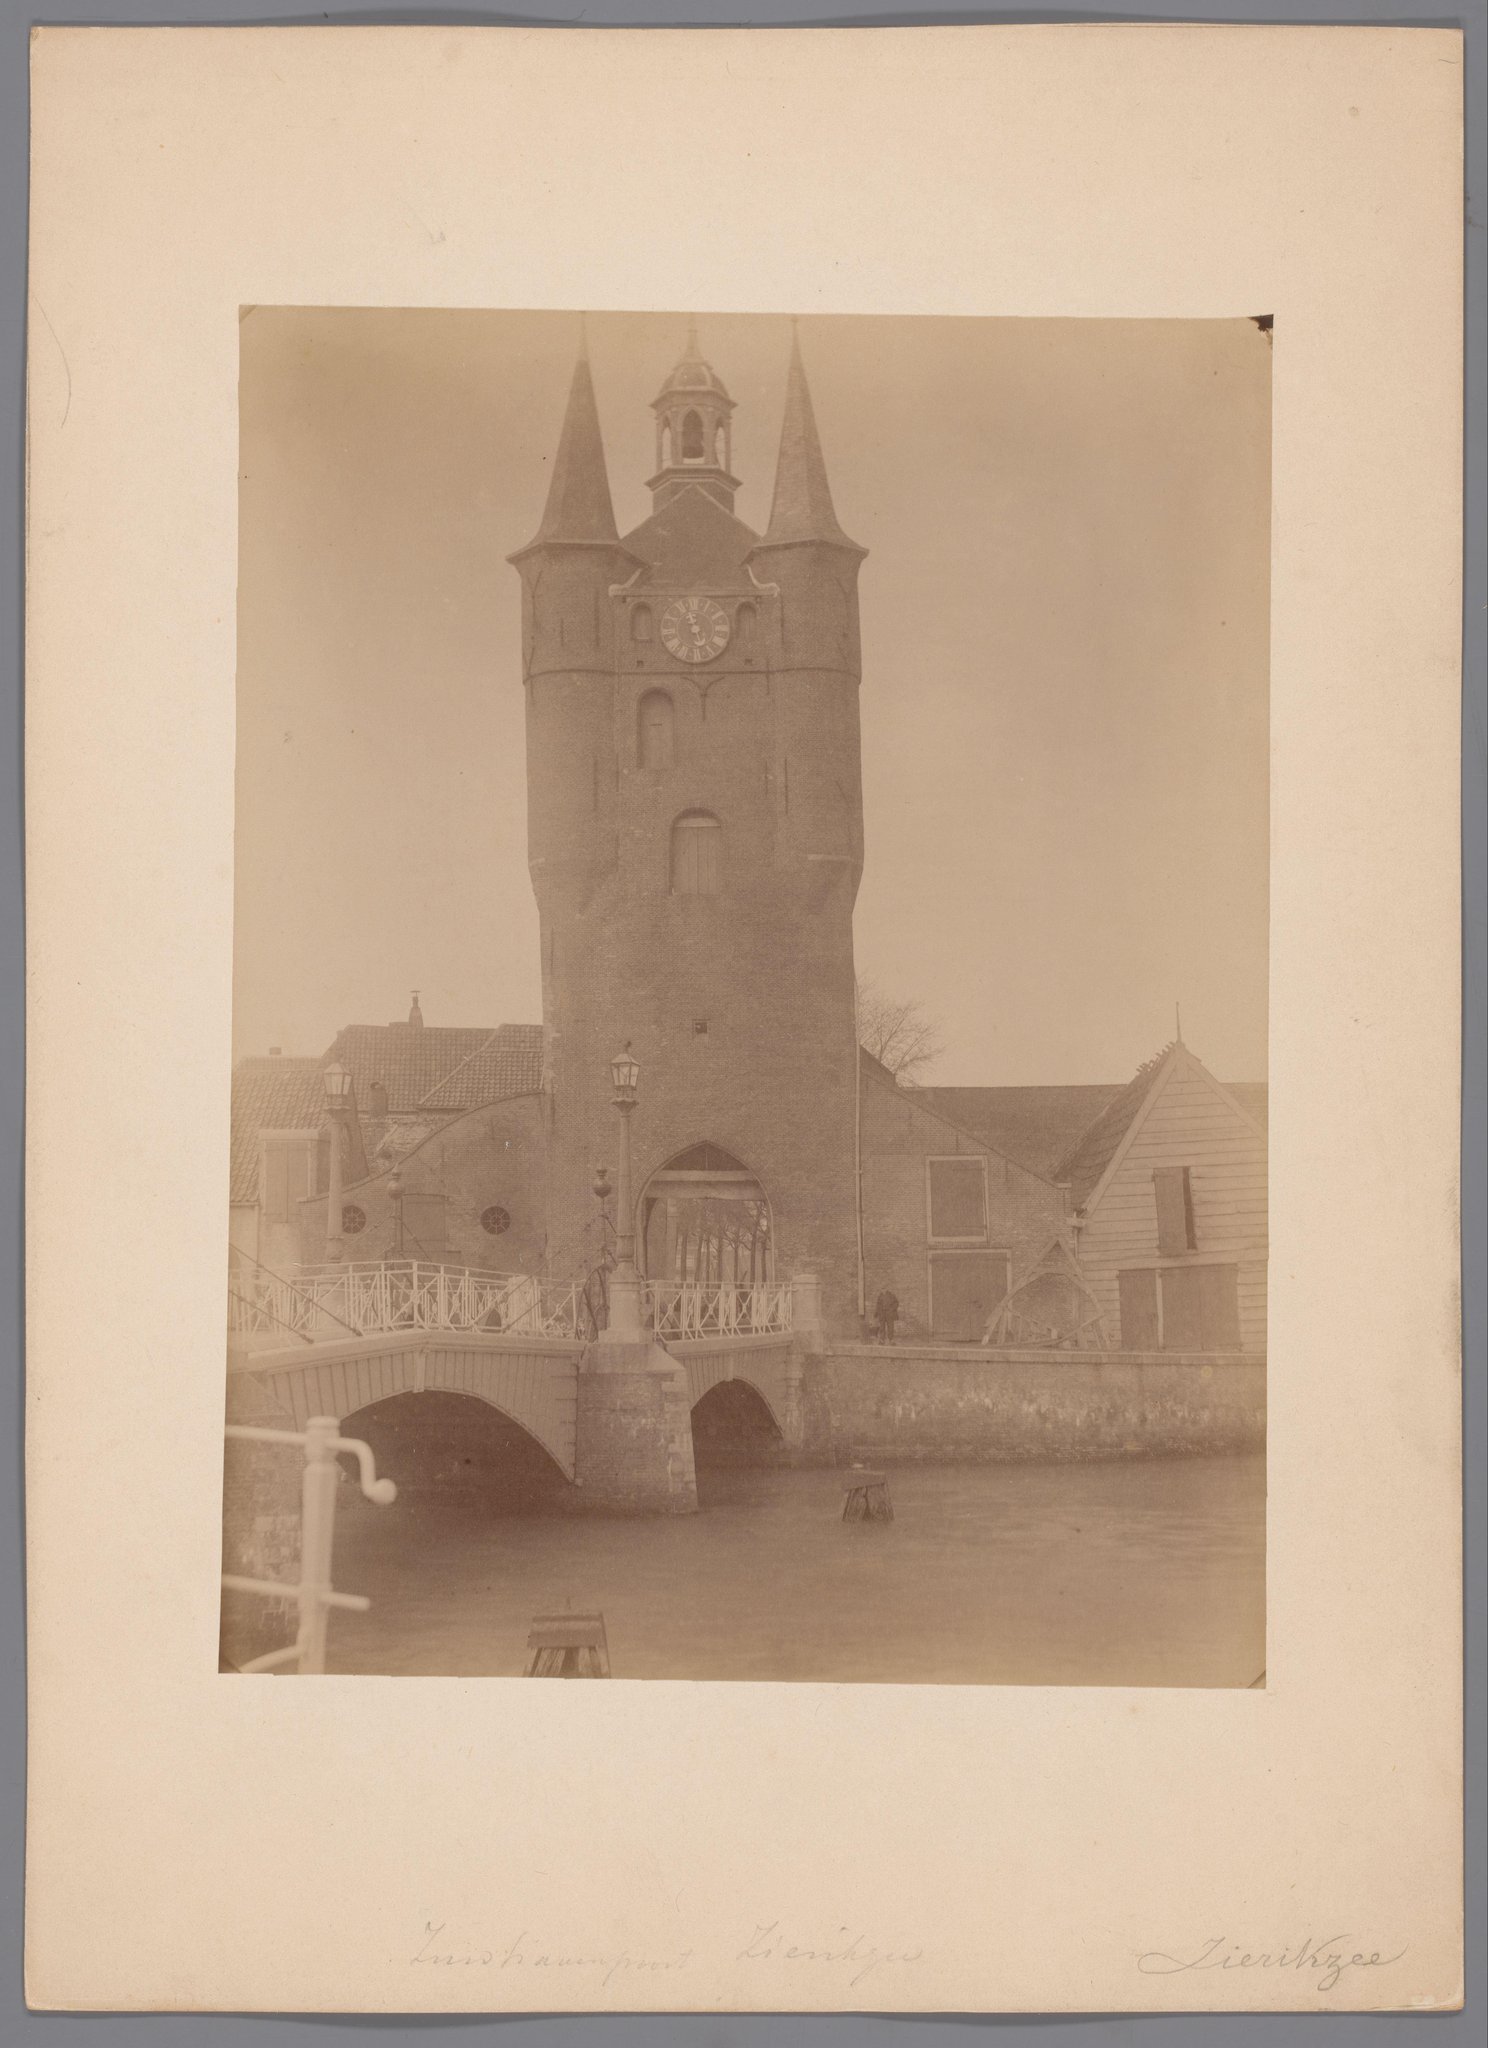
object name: photograph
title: Gezicht op de Zuidhavenpoort te Zierikzee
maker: anoniem (monumentenzorg)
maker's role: fotograaf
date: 1893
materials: cardboard, photographic support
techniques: albumen print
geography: zierikzee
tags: gate, entrance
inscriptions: annotation: ‘Zuidhavenpoort Zierikzee/ Zierikzee’, annotation: ‘Zierikzee/ Zuid-haven of Duivelandschepoort (buitenzijde)/ Maart 1893’